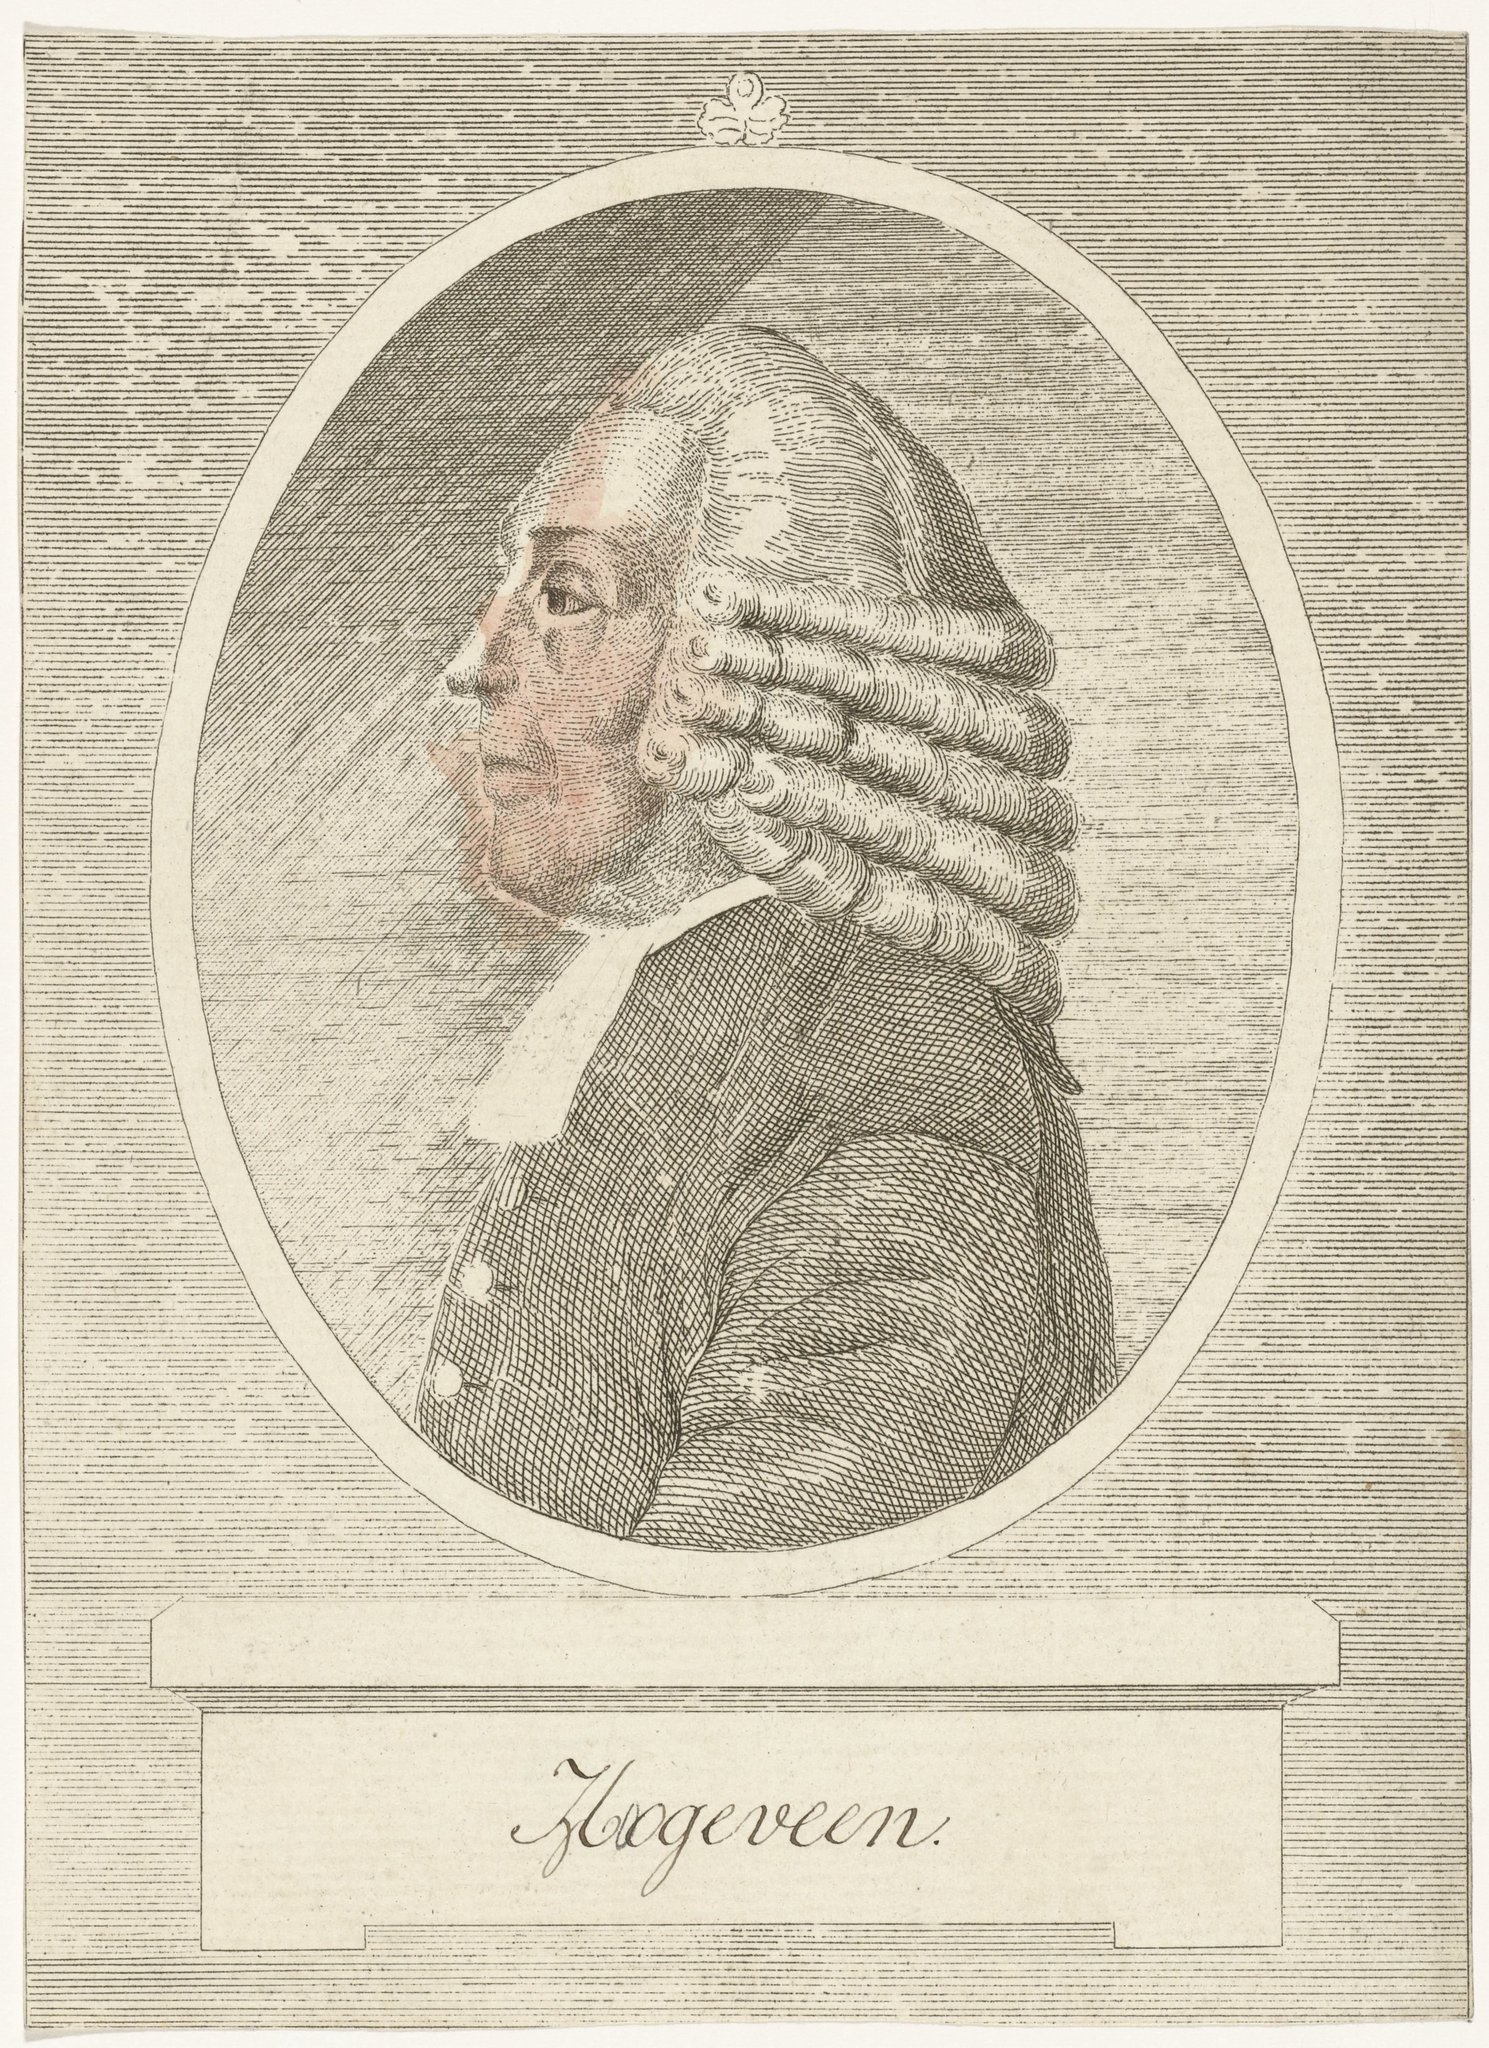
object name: print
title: Portret van Henricus Hoogeveen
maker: pieter de mare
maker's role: print maker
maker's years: 1758-1796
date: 1768-1796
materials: paper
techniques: brush, etching, pen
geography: leiden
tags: henricus hoogeveen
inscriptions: collector's mark: Lugt 2228